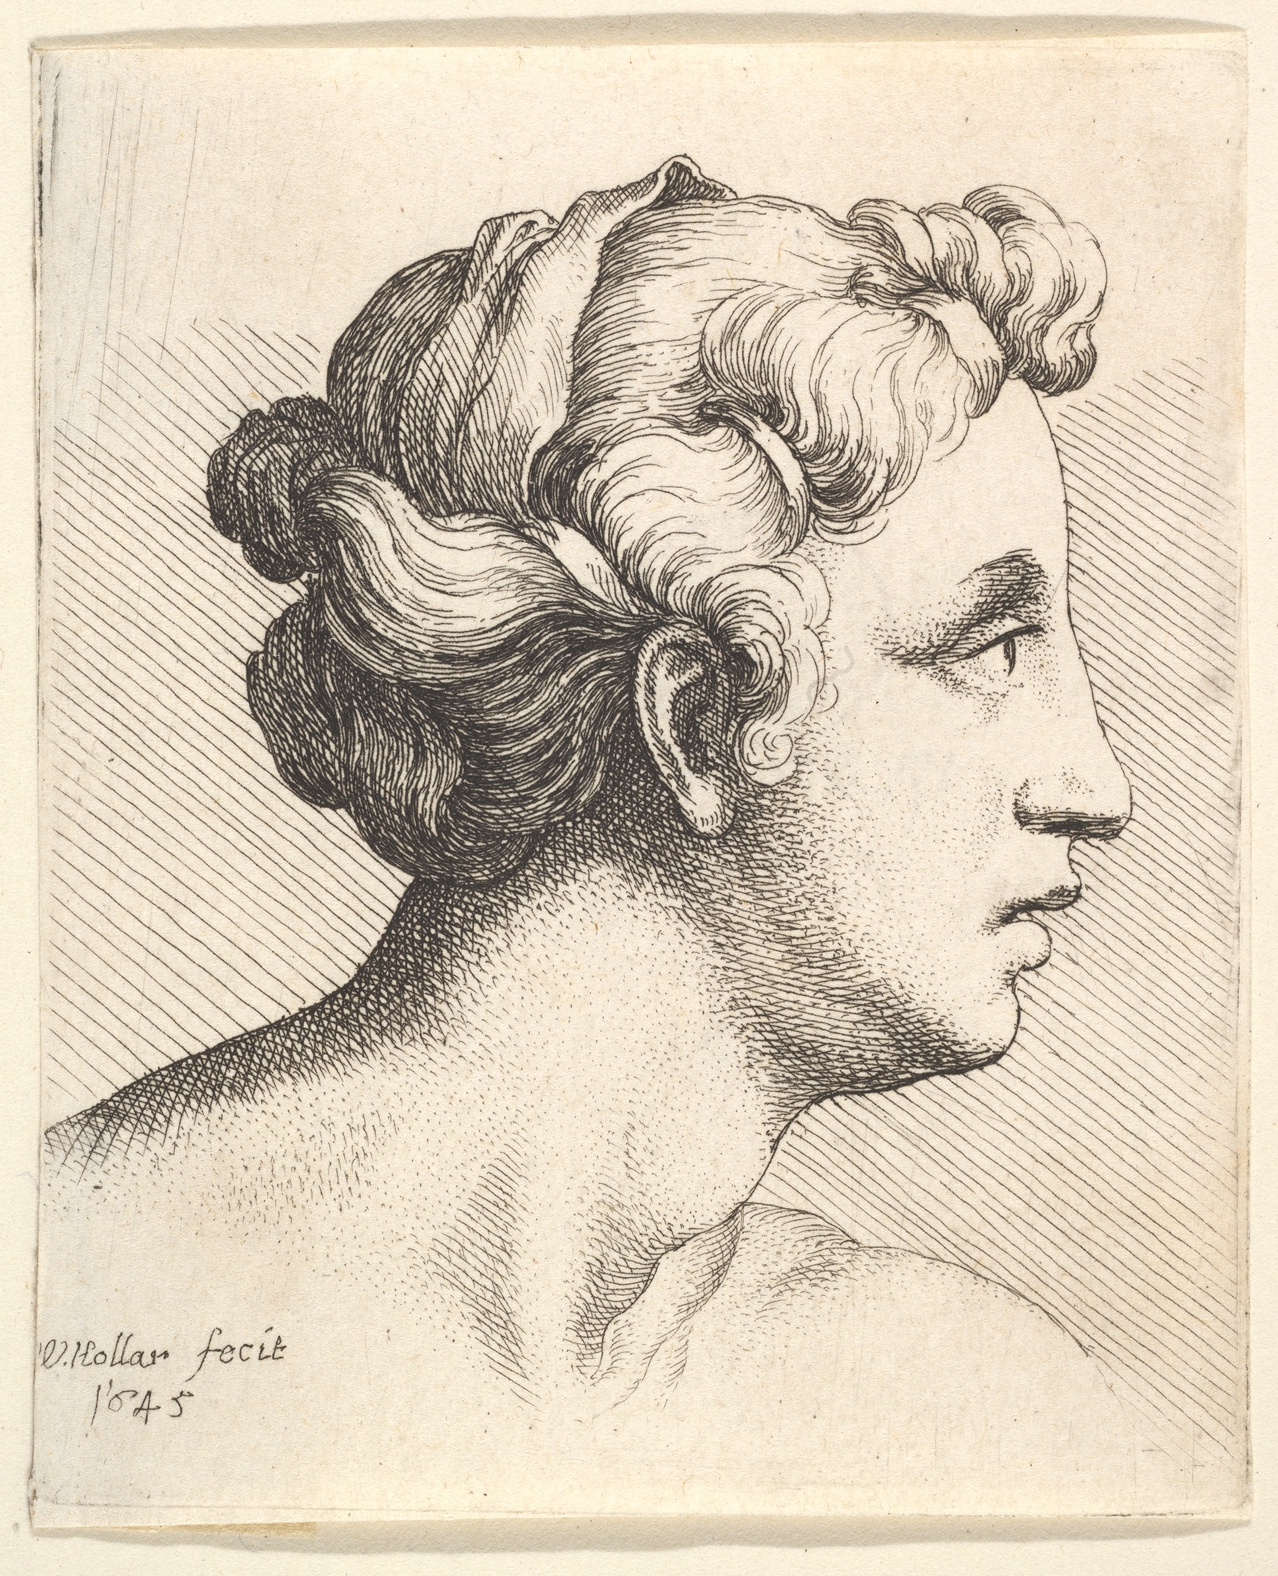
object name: print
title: Woman with a bound tress of hair in profile to right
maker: wenceslaus hollar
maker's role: artist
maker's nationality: bohemian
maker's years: 1607-1677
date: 1645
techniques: etching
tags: women